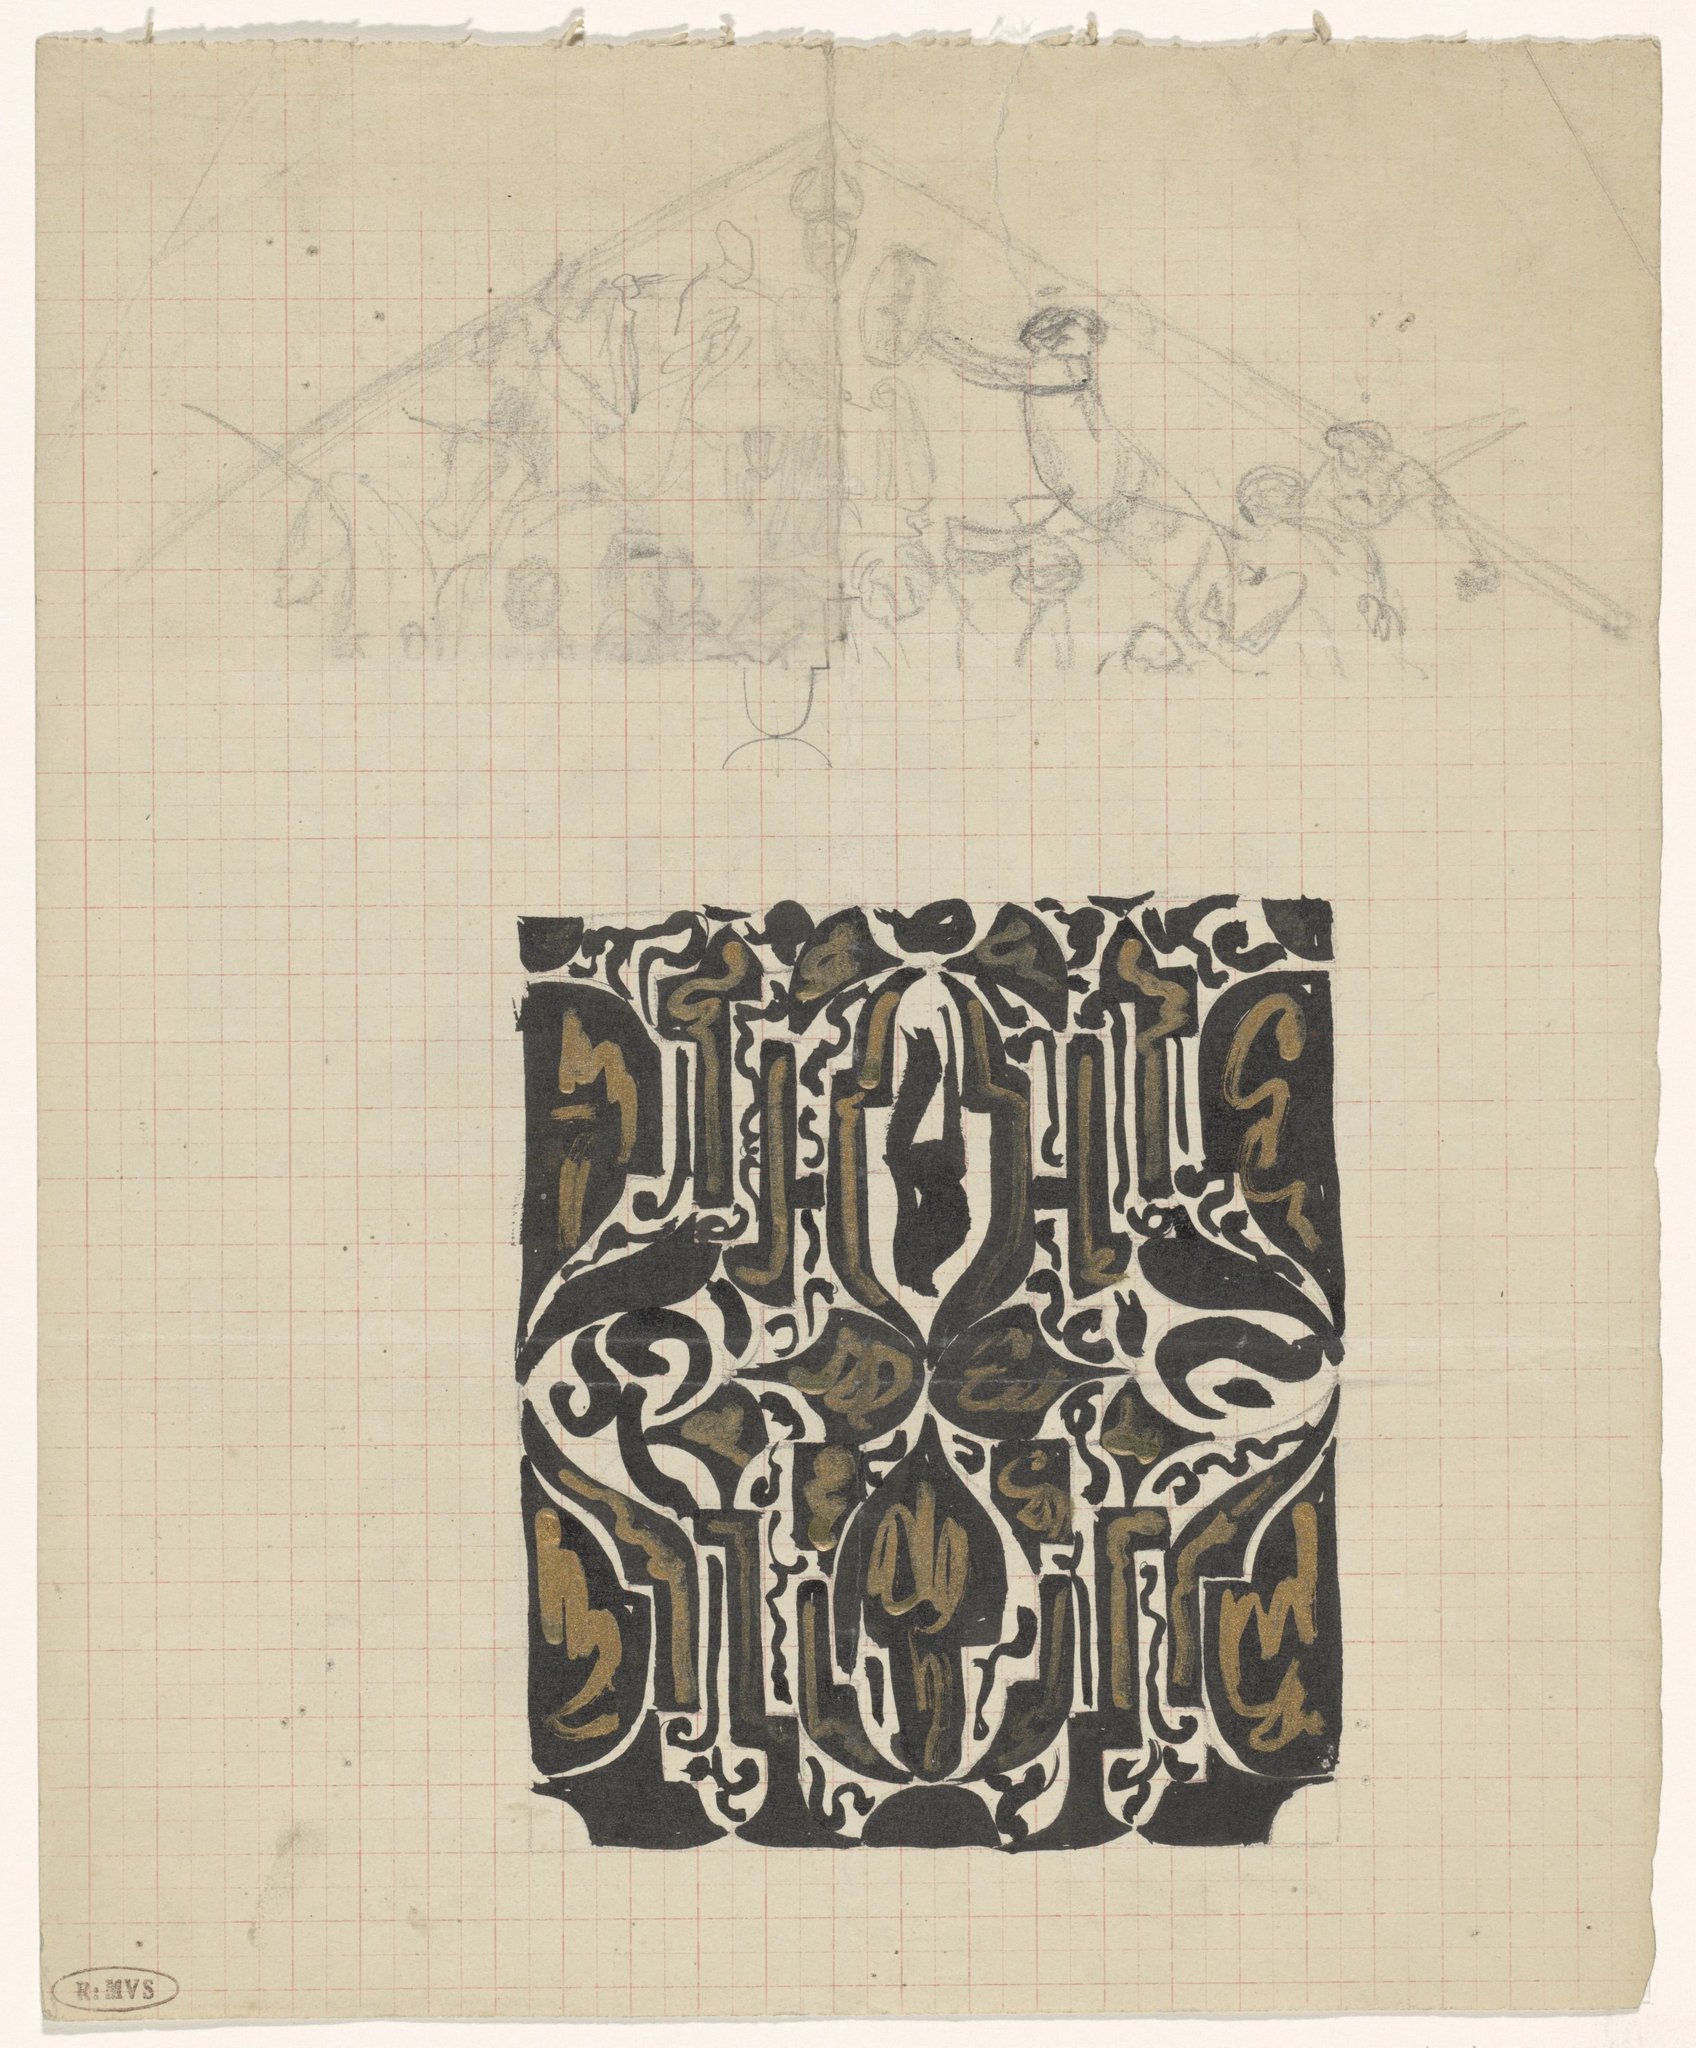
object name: drawing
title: Decoratief ontwerp en schets van het front timpaan van het Koninklijk Paleis te Amsterdam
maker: carel adolph lion cachet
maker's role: draughtsman, print maker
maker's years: 1864-1945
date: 1874-1945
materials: paint, paper, pencil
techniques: brush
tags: ornaments ~ art, piece of sculpture, reproduction of a piece of sculpture, front façade, amsterdam